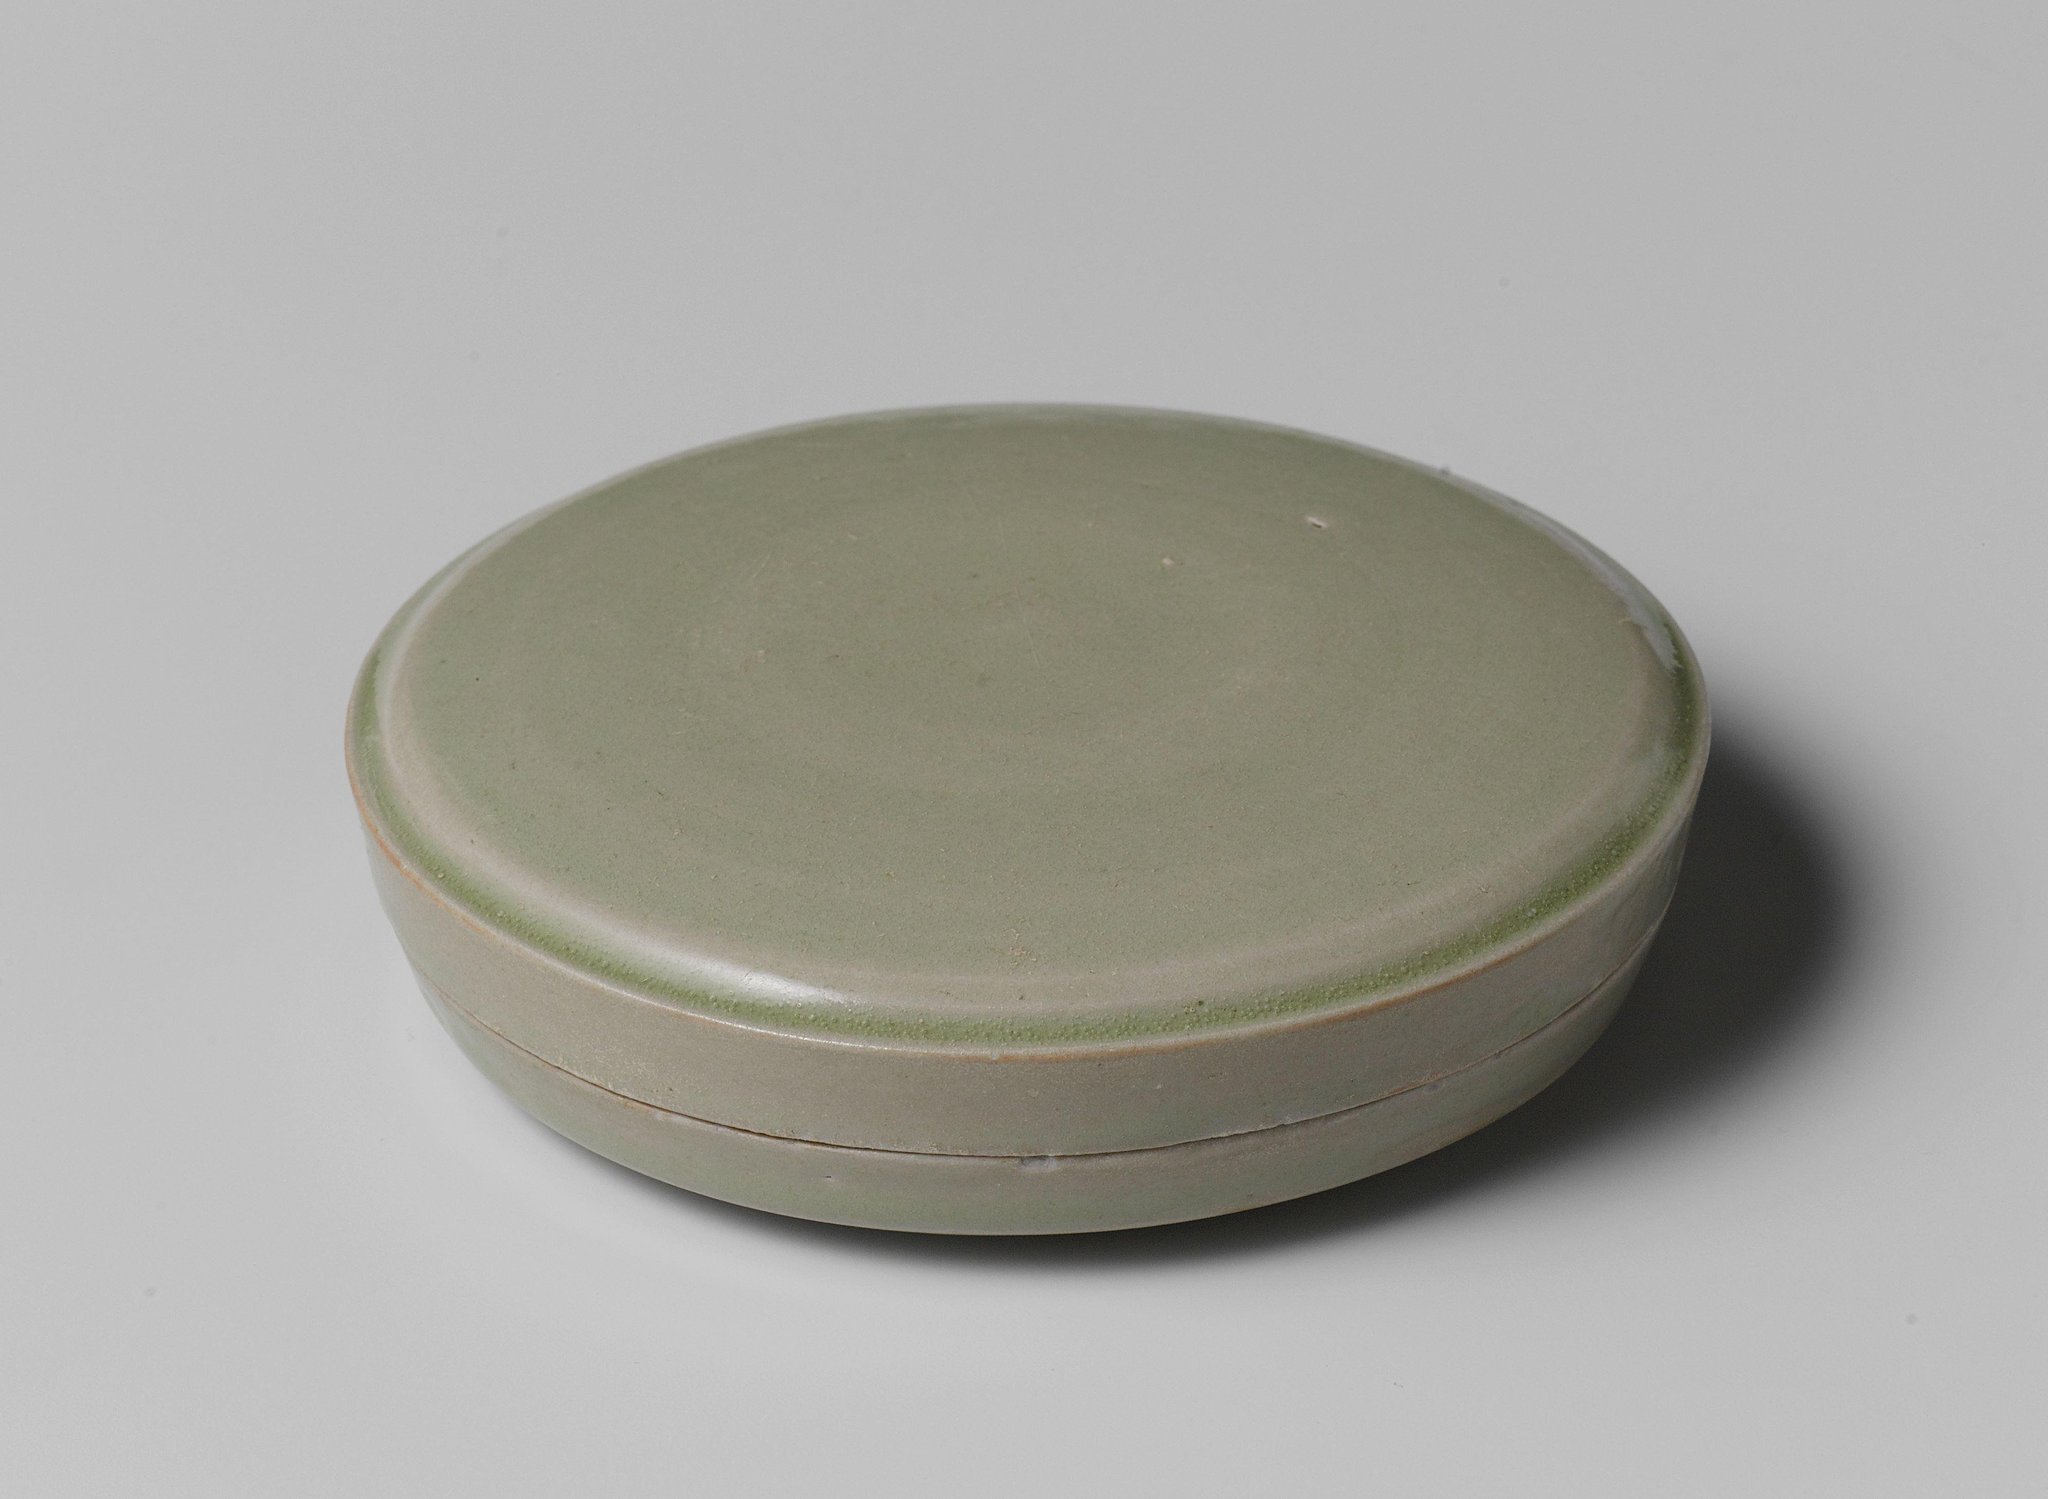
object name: box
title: Round box with a green glaze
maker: Anonymous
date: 900-999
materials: glaze, stoneware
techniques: firing, turning, vitrification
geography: china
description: Ronde doos van steengoed, bedekt met een groen glazuur. Op de onderzijde zes ongeglazuurde velden. Celadon (Yue).